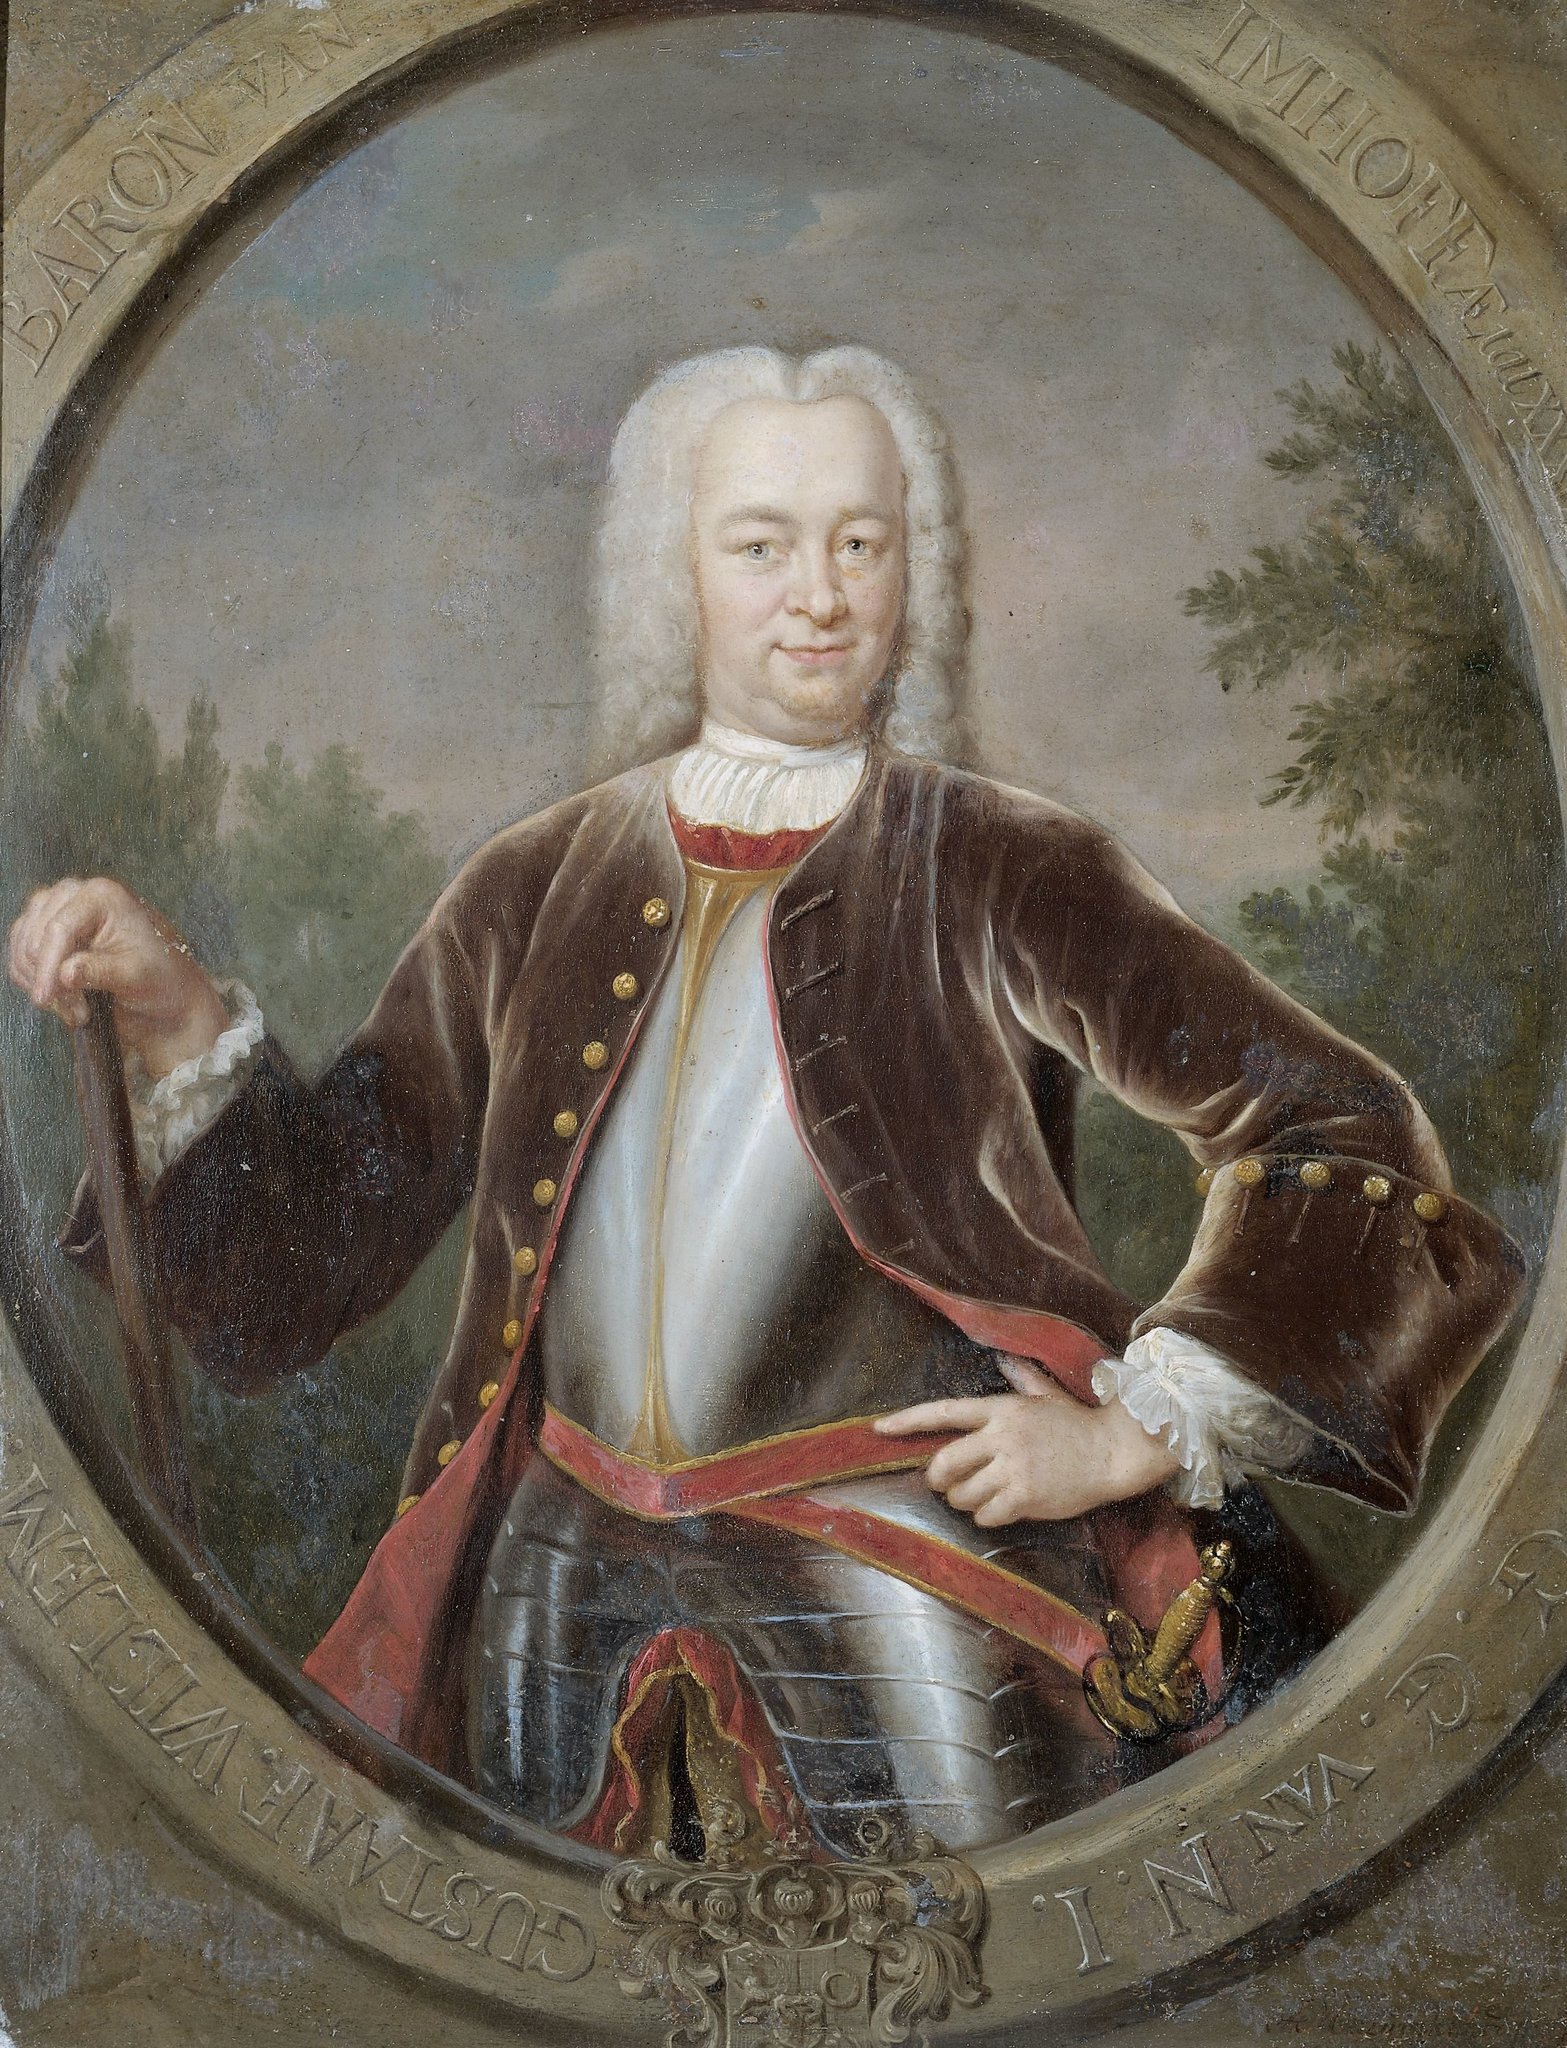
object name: painting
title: Portrait of Gustaaf Willem, Baron van Imhoff, Governor-General of the Dutch East India Company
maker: jan maurits quinkhard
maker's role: draughtsman, painter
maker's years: 1688-1772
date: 1742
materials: copper, oil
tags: batavia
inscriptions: inscription: ‘Gustaaf Willem Baron van Imhoff aetat XXXVIII G.G. van N.I.’, signature and date: ‘J.M. Quinkhard pinxit 1742’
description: Portret van Gustaaf Willem baron van Imhoff (1705-50). Gouverneur-generaal (1743-50). Ten halven lijve, in wapenrusting in ovaal, aanziend. De rechterhand leunend op de commandostaf, de linkerhand in de zij. Op de achtergrond geboomte. Onderdeel van een reeks van kopieën naar portretten van de gouverneurs-generaal van het voormalige Nederlands Oost-Indië, waarschijnlijk afkomstig van de Verenigde Oostindische Compagnie.